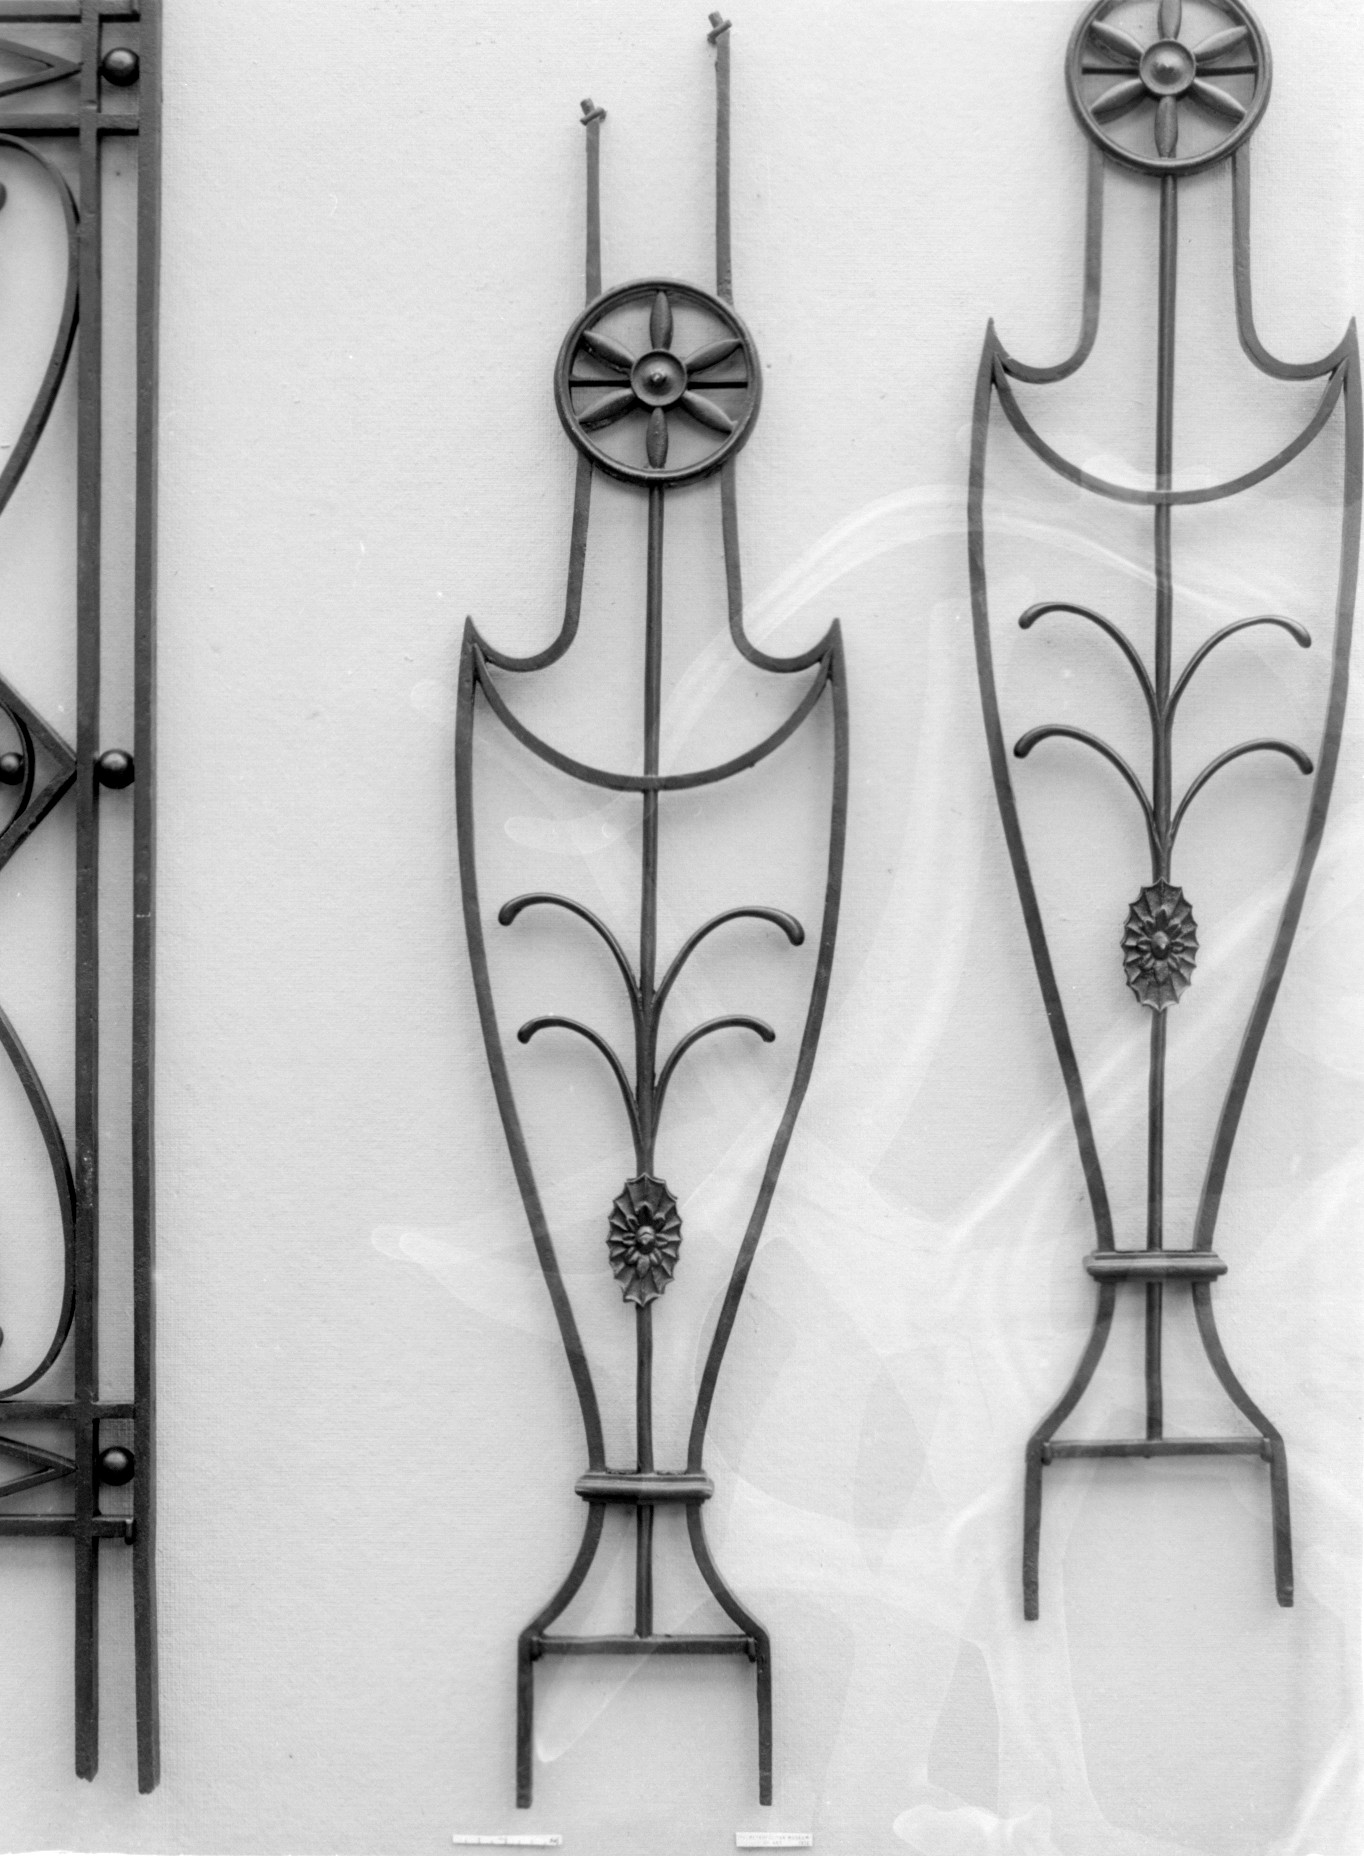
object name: baluster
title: Baluster (one of pair)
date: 1701-1800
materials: brass, iron